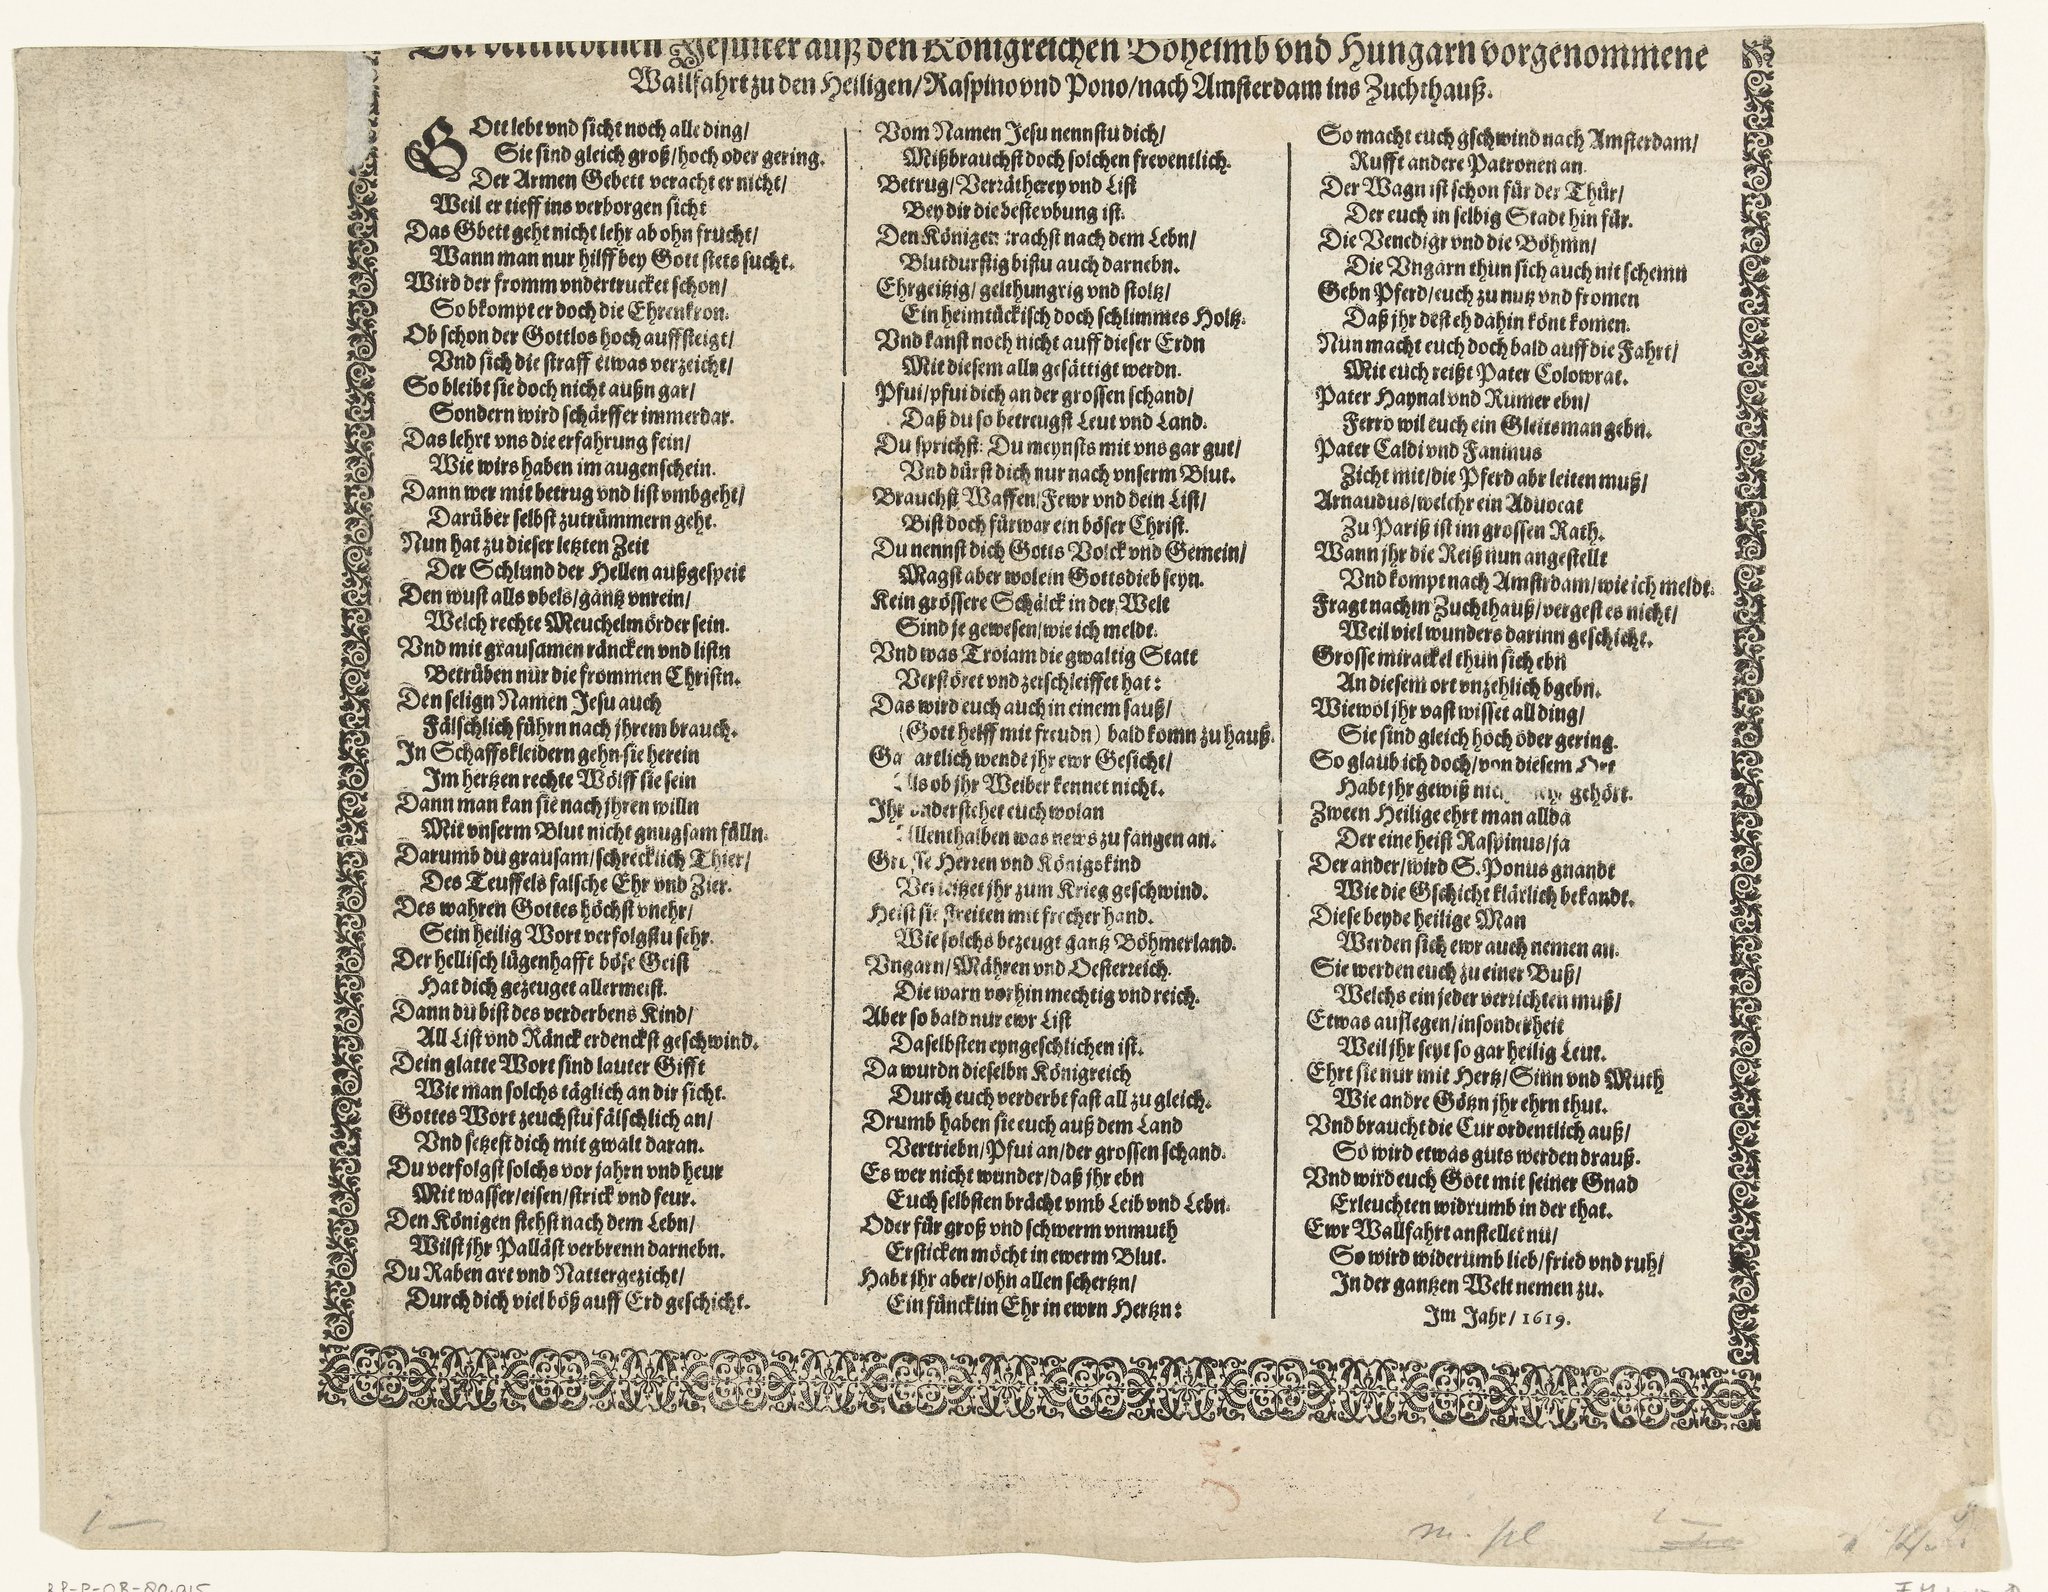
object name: text sheet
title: Der Vertriebenen Jesuiter aus den Königreichen Böheimb und Hungern vorgenommene Wallfarth zu dem Heiligen Raspino und Pono / nach Amsterdam ins Zuchthauß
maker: Anonymous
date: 1619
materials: paper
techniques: letterpress printing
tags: amsterdam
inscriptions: date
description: Tekstblad met een Duits vers over drie kolommen, gebruikt bij de spotprent met een voorstelling van de tocht van de in 1619 uit Bohemen en Hongarije verdreven jezuïeten naar het rasphuis in Amsterdam. Bedrukt op de achterzijde van een Duitse allegorische voorstelling Der trewhertzige gute Eckhart uit 1620.